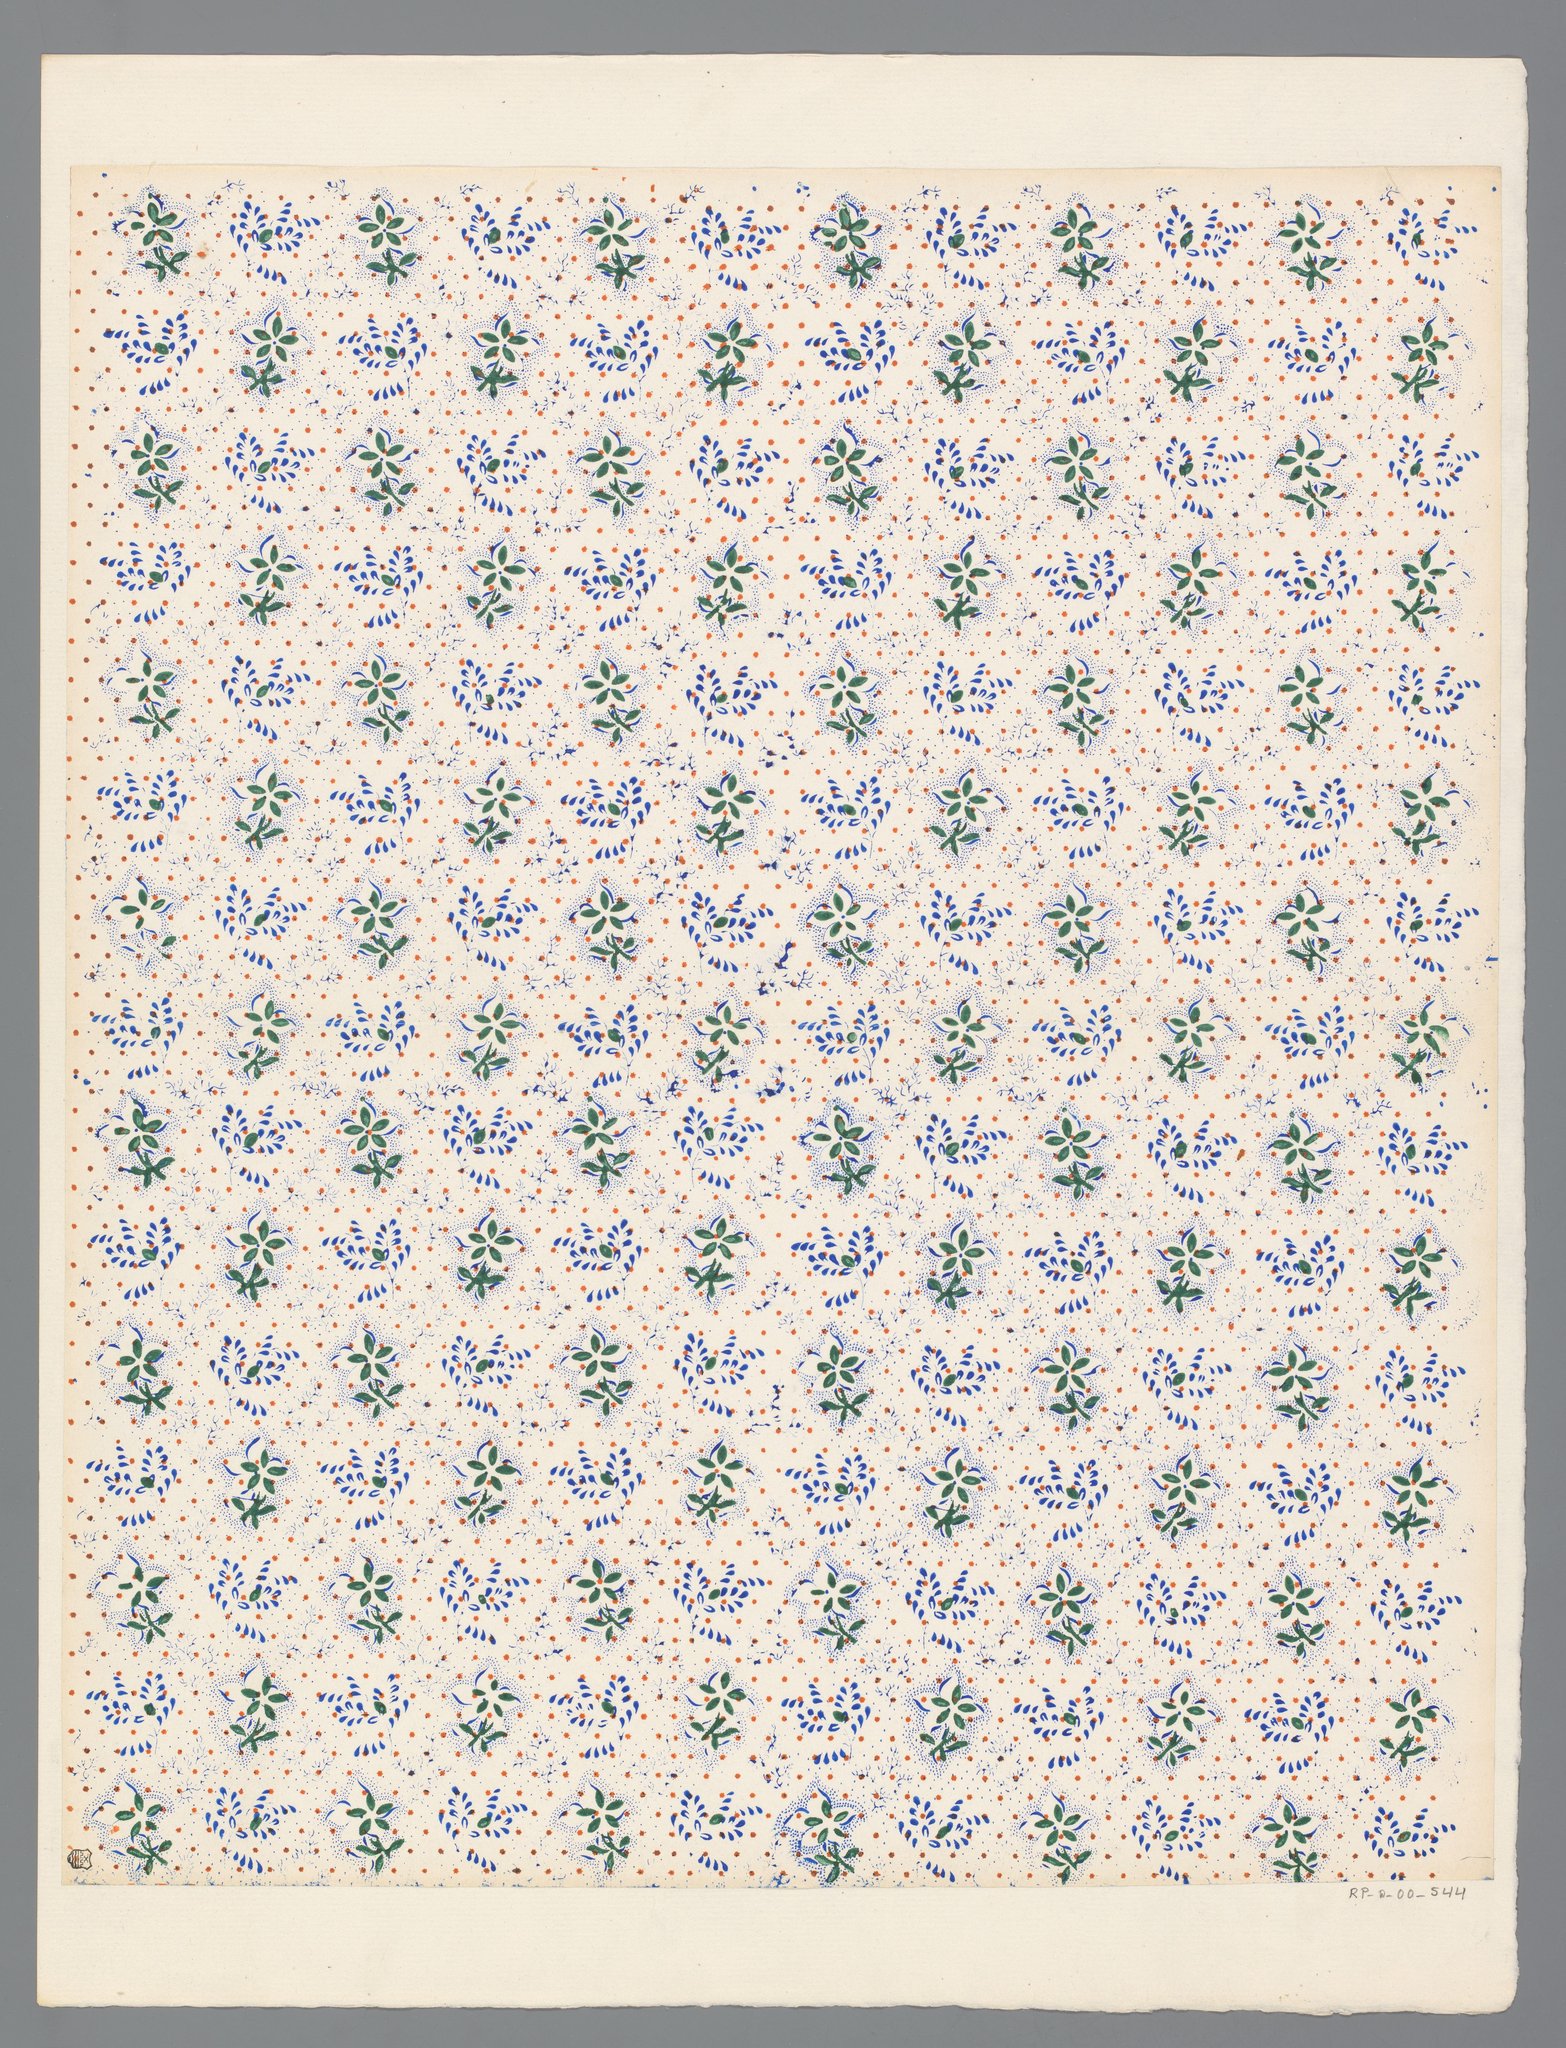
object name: printed paper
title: Blad met strooipatroon van afwisselend bloemmotief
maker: Anonymous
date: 1800-1900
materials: paper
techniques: printing block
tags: ornament derived from plant forms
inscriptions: collector's mark: Lugt 2760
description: Blad met strooipatroon van afwisselend bloemmotief omgeven door stippen.